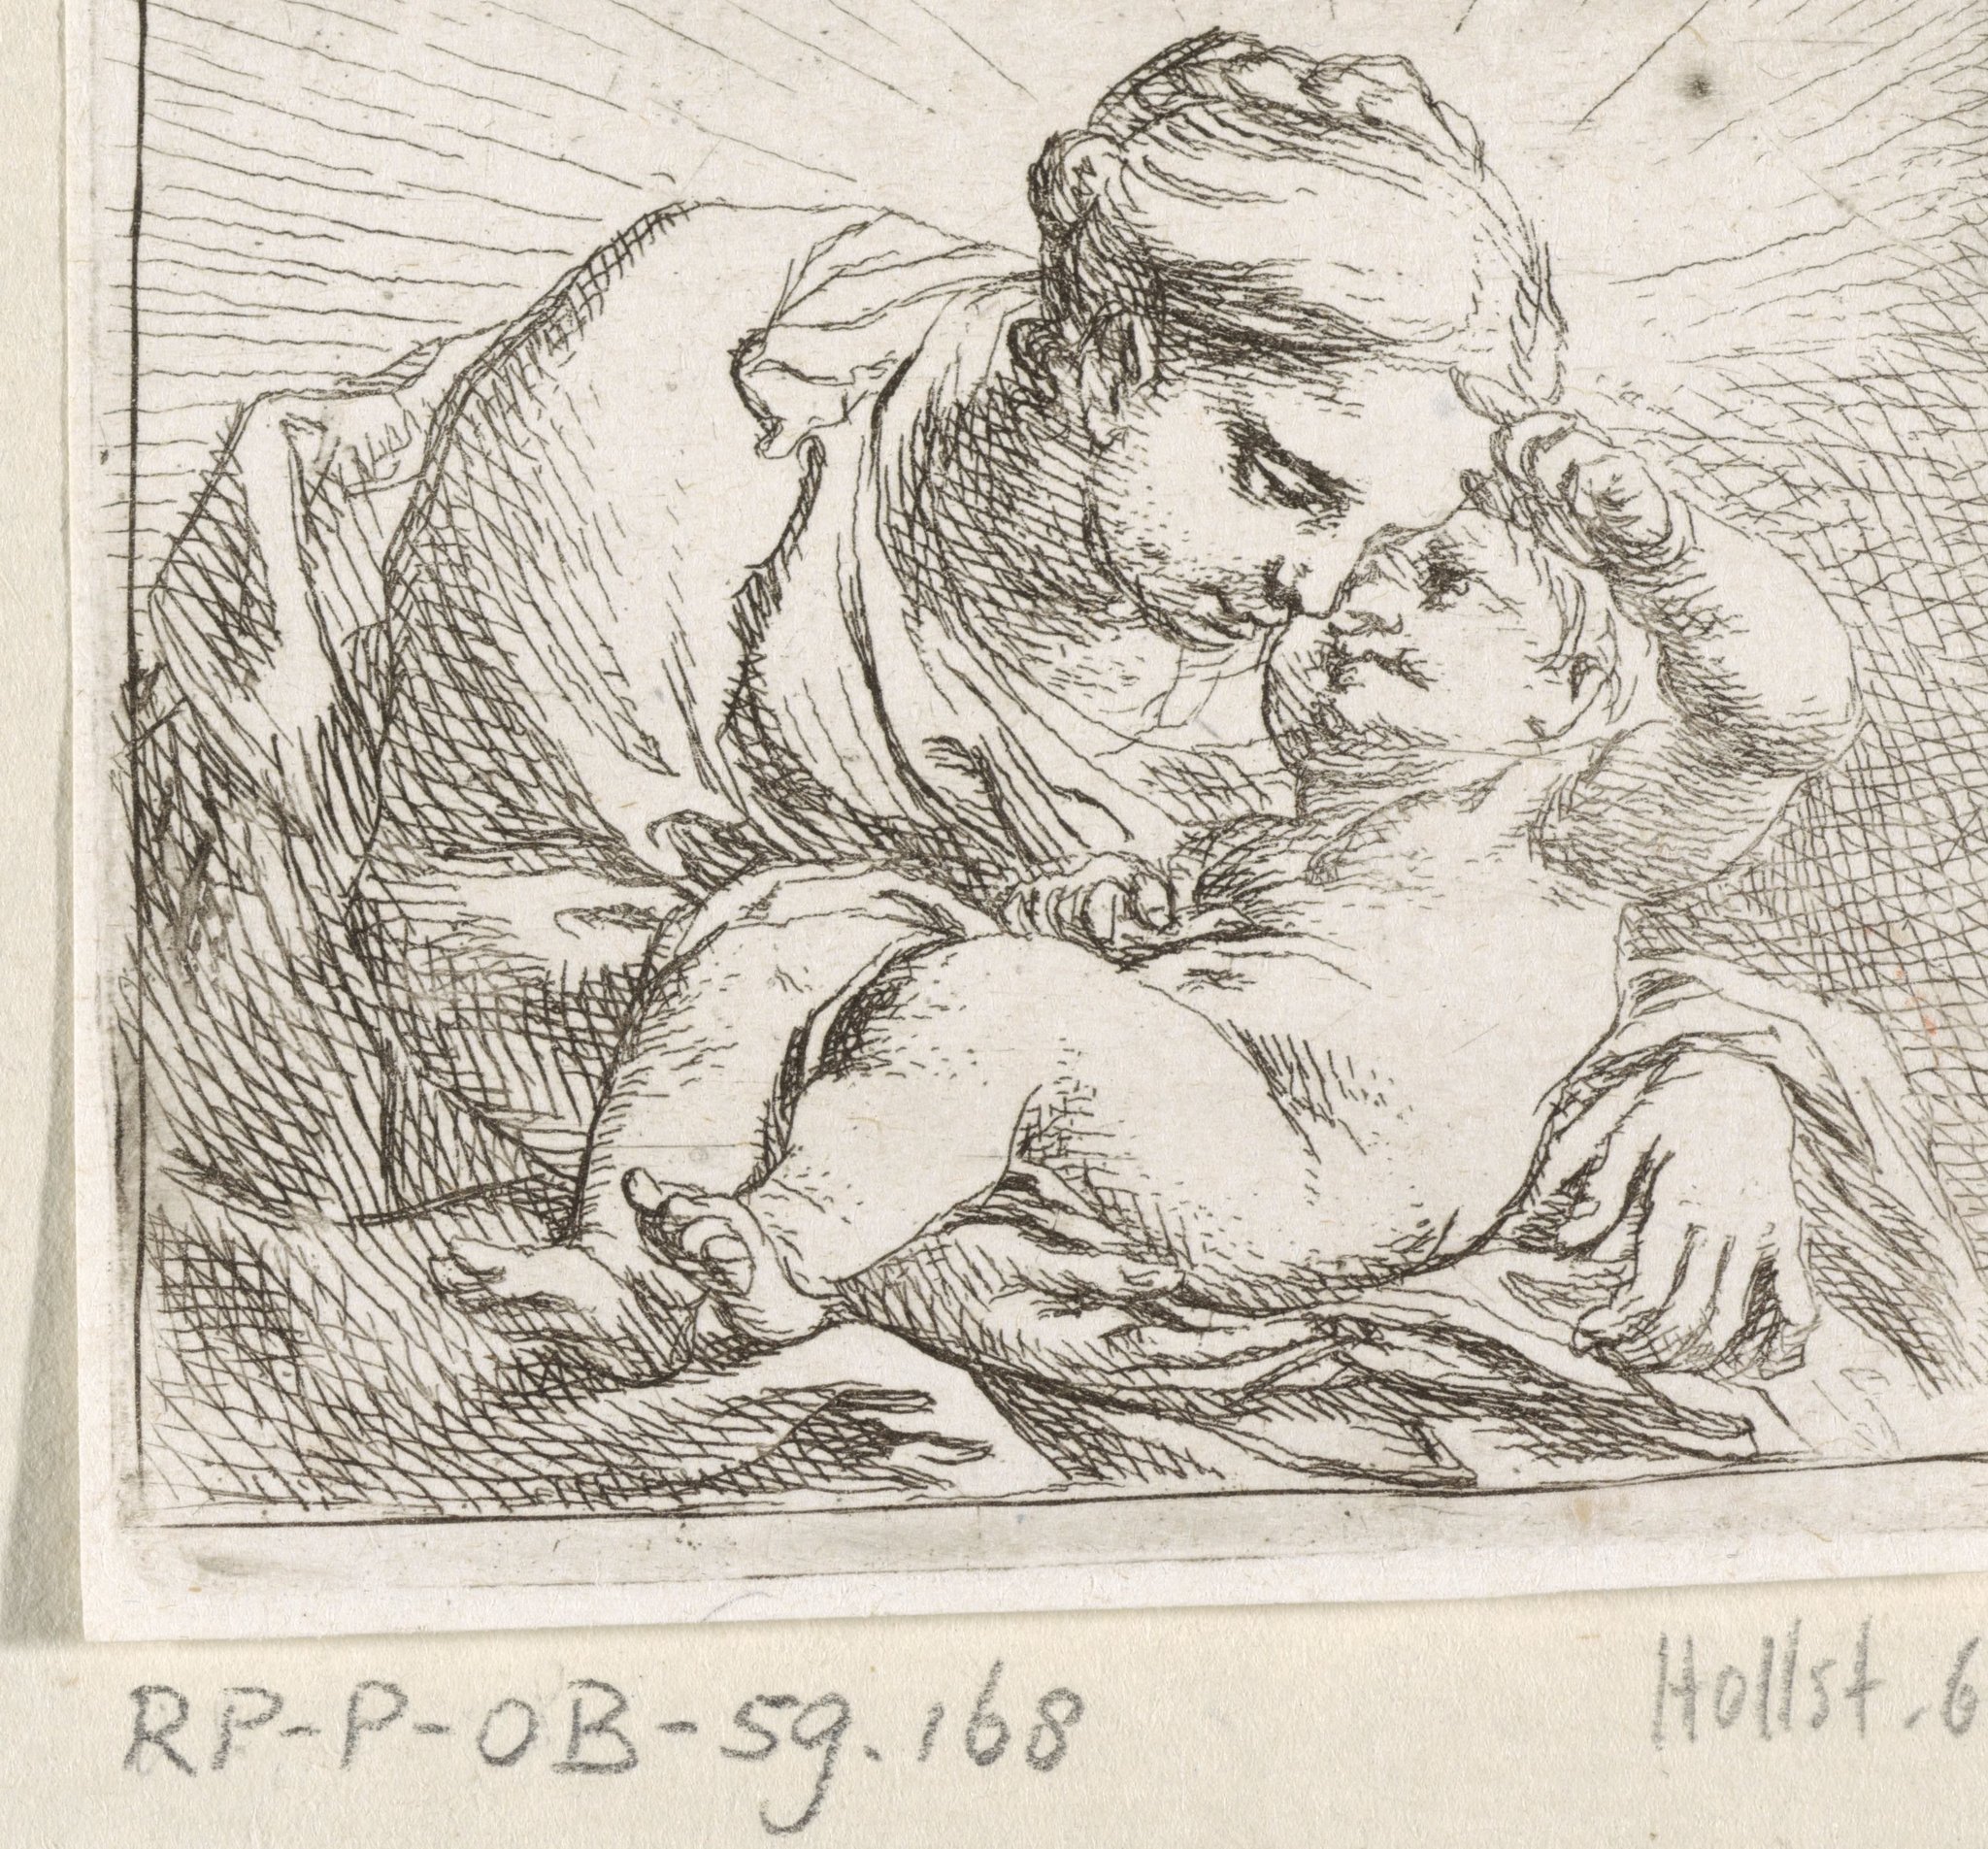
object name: print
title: Madonna met kind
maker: cornelis schut (i)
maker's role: draughtsman, print maker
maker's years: 1597-1655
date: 1618-1655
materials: paper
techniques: etching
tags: mary standing (or half-length), the christ-child in front of her, close to her bosom; lying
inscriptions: collector's mark: Lugt 240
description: Maria buigt zich voorover om het liggende Christuskind om te tillen. Hij reikt met zijn arm omhoog naar haar.